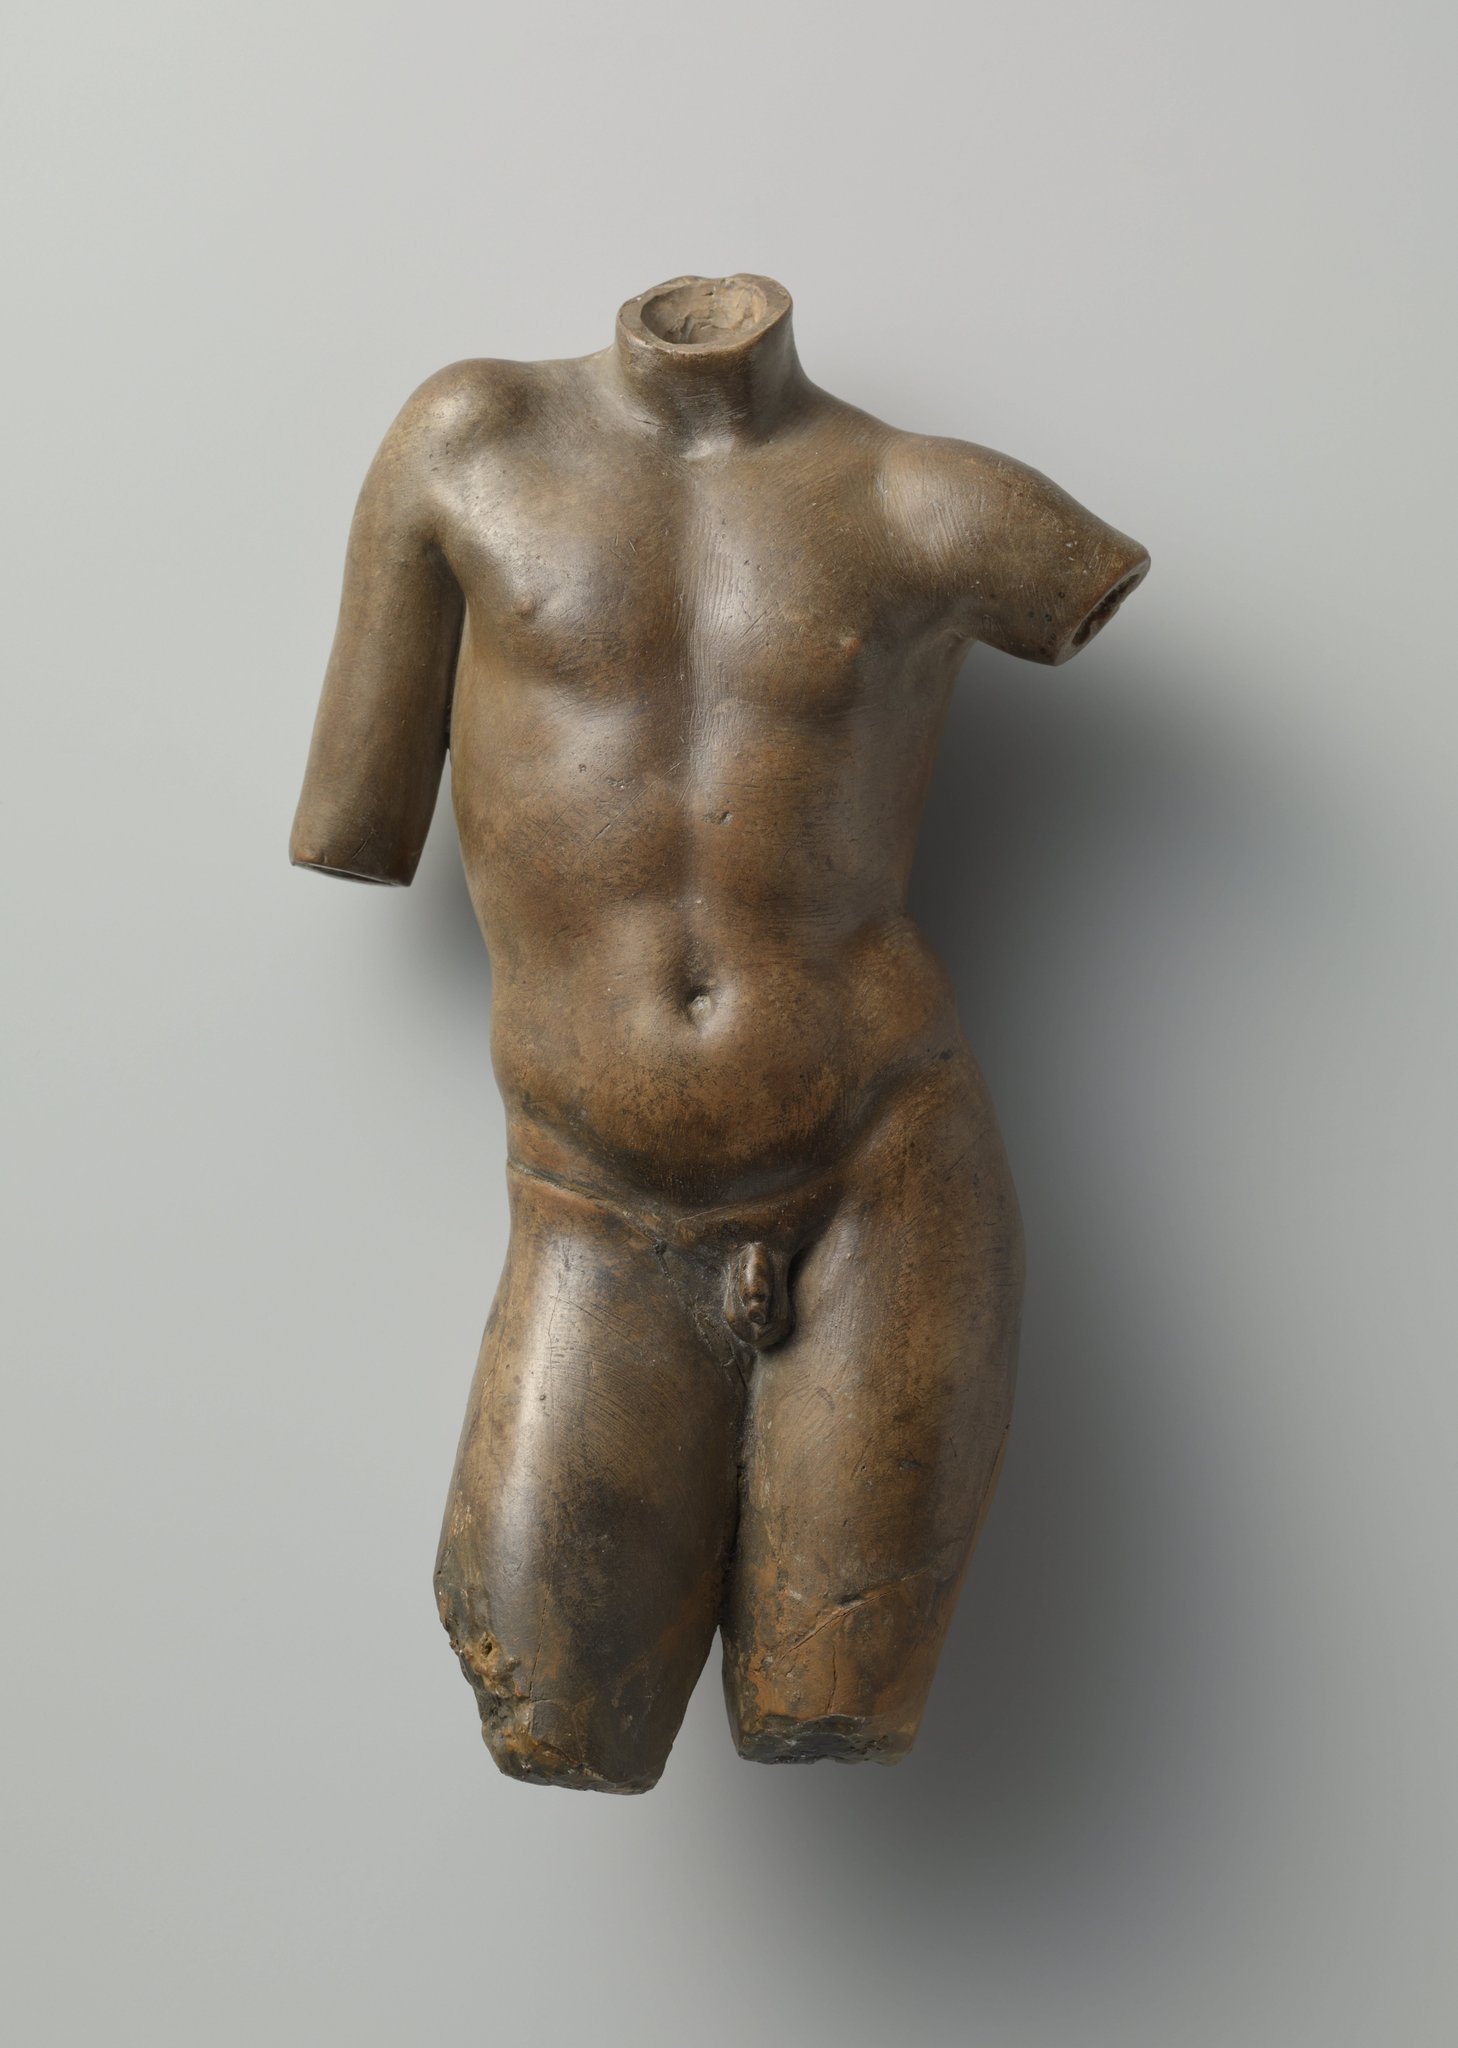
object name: model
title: Study Models of Parts of the Body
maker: johan gregor van der schardt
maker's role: sculptor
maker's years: 1530-1581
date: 1560-1570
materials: terracotta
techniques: molding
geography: florence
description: This group of small models of parts of the body are carefully copied after famous sculptures, in particular by Michelangelo, in Florence and Rome. They came from the workshop of the Nijmegen sculptor Johan Gregor van der Schardt, who had a successful career in Italy, Nuremberg, and Copenhagen. They are extremely rare examples of the, in part autograph, study material of a 16th-century sculptor.